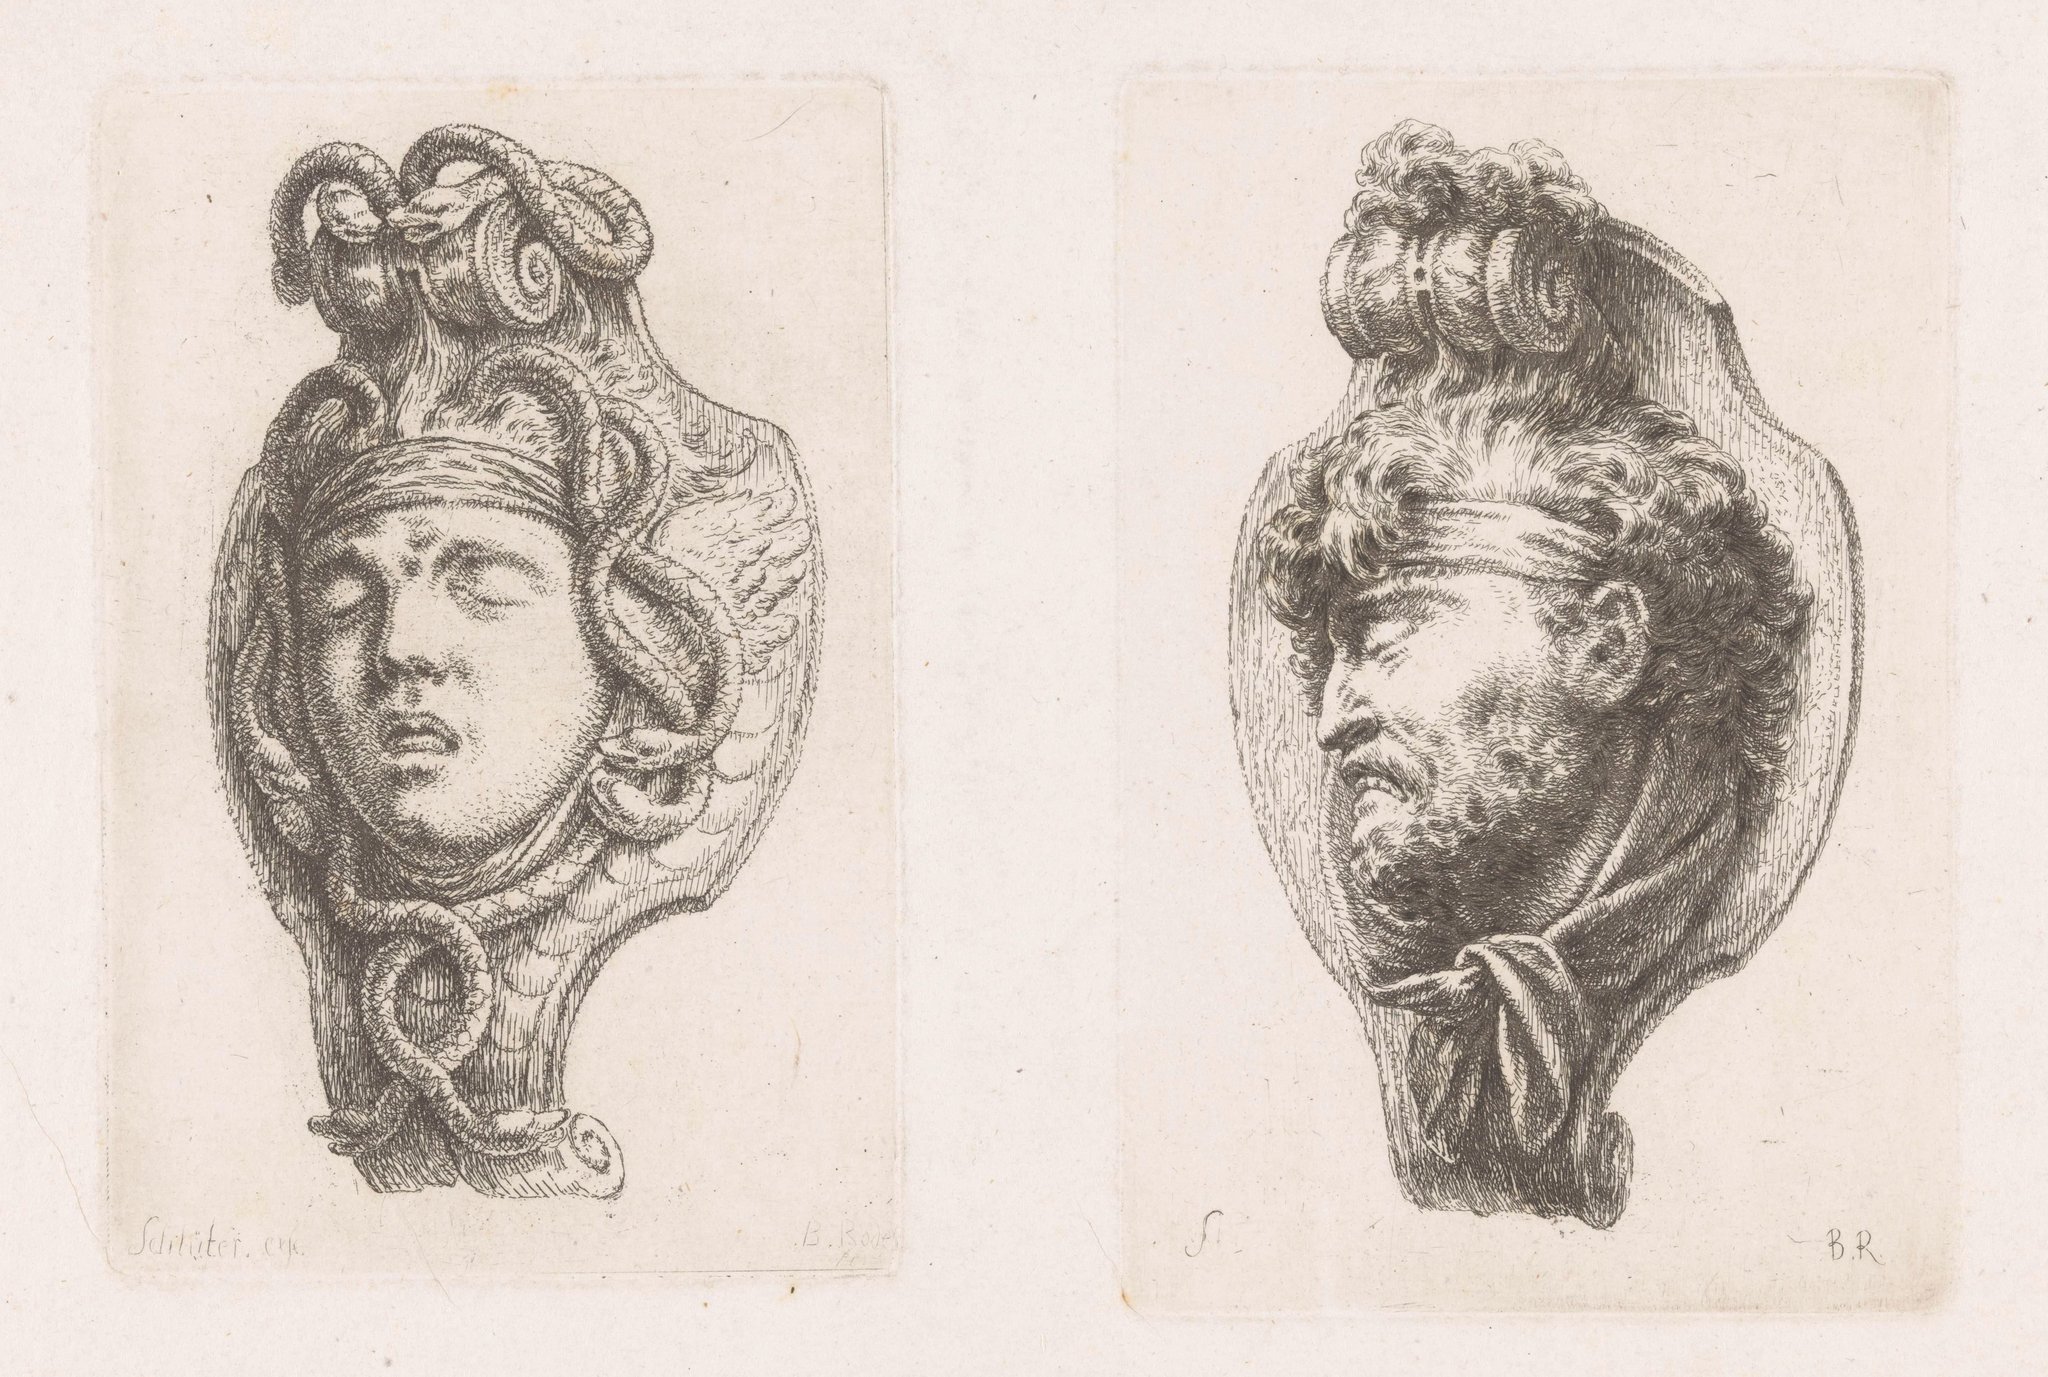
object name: print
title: Mascarons en helmen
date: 1759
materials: paper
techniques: etching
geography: berlin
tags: medusa (one of the gorgons), mask, mascaron ~ ornament, the soldier; the soldier's life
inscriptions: collector's mark: Lugt 2228, collector's mark: Lugt 2760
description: Prent is gemaakt naar de sculpturen van Andreas Schlüter in het Zeughaus (tegenwoordig het Deutsches Historisches Museum) te Berlijn. Mogelijk prent uit: Rode, Bernhard. Larven nach den Modelen des berühmten Schlüters gezeichnet und in Kupfer geätzt von B. Rode. Berlijn: Rode, Heinrich, 1759.